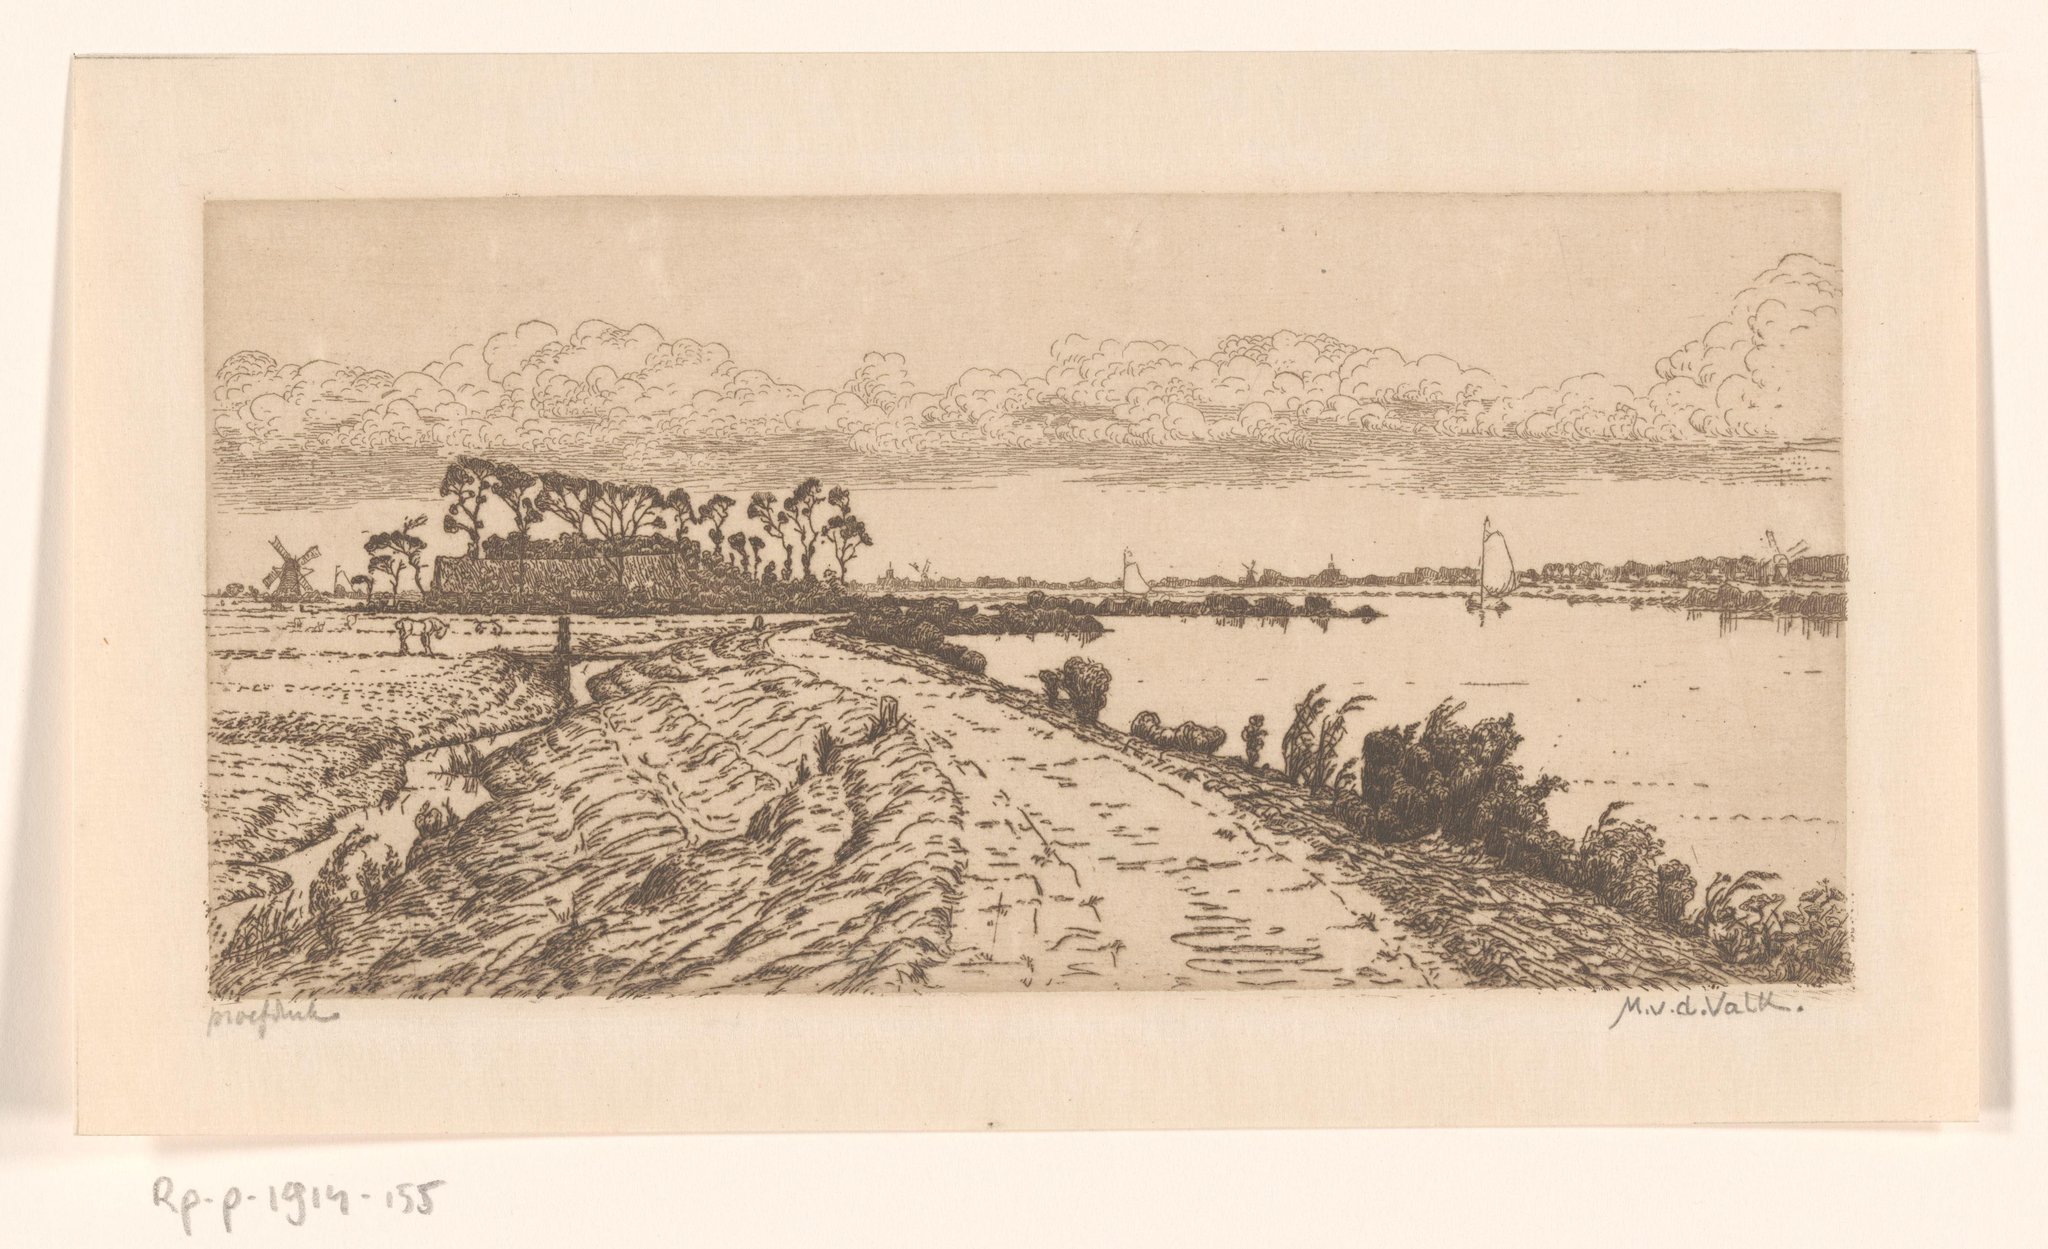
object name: print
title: Landschap met landweg, meer en weiland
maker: maurits van der valk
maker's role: draughtsman, print maker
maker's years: 1857-1935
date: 1867-1914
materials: paper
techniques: etching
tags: meadow, pasture, lake, road, path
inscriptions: collector's mark: Lugt 2233